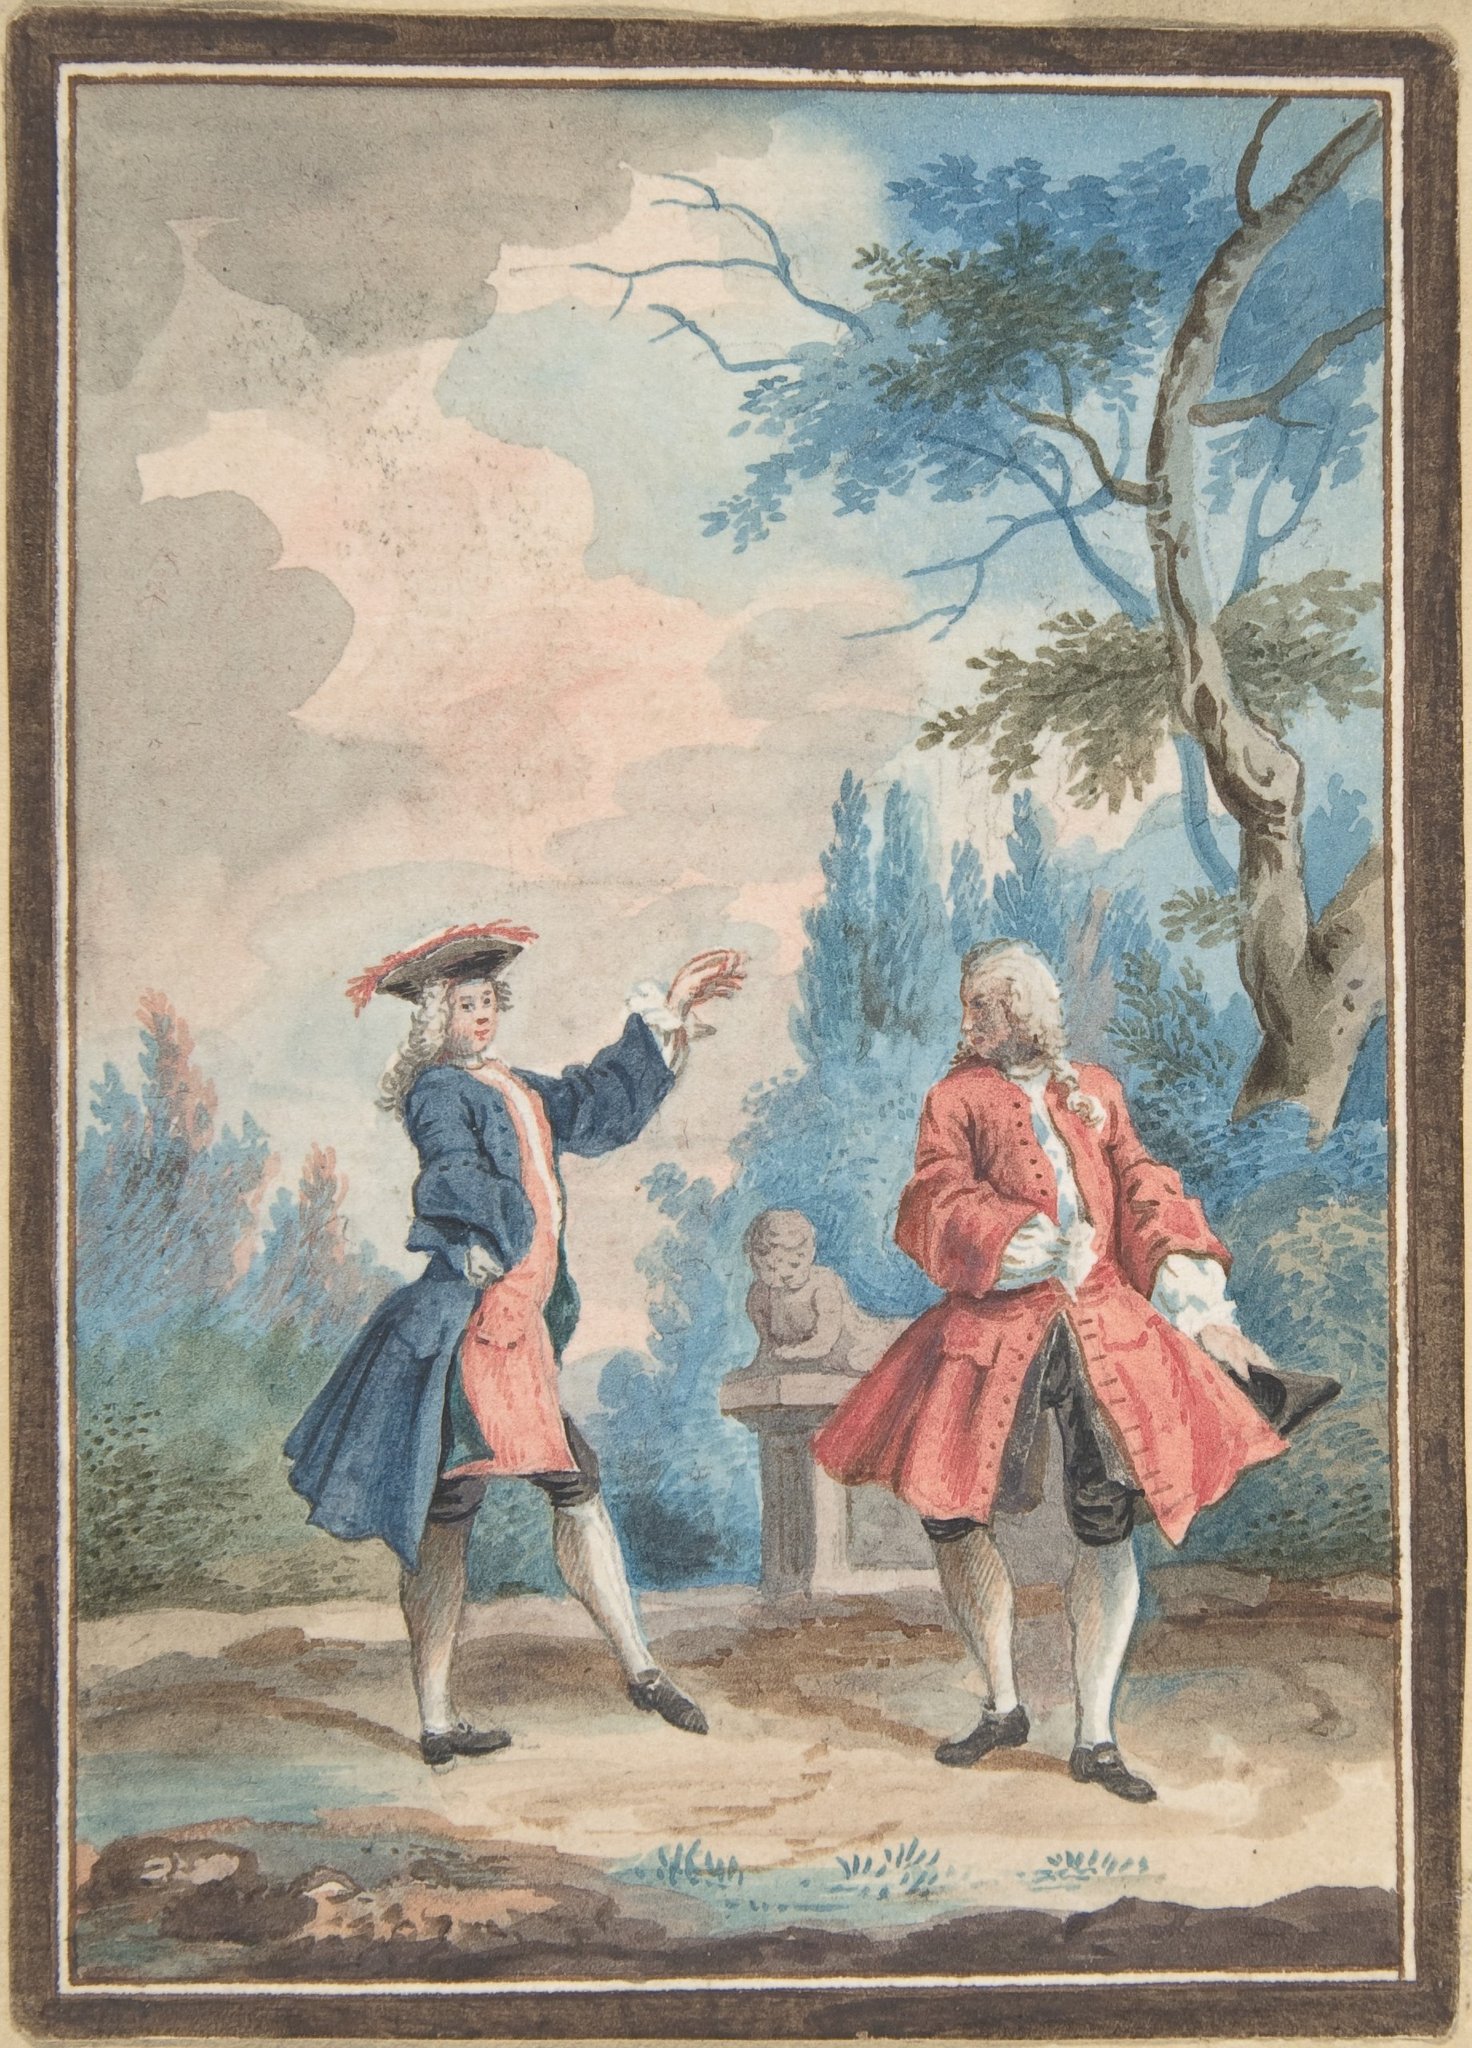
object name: drawing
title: Two dancing male figures in a landscape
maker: anonymous, french, 18th century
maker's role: artist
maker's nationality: french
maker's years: 1700-1800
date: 1701-1800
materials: gouache, ink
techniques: pen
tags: men,dancing